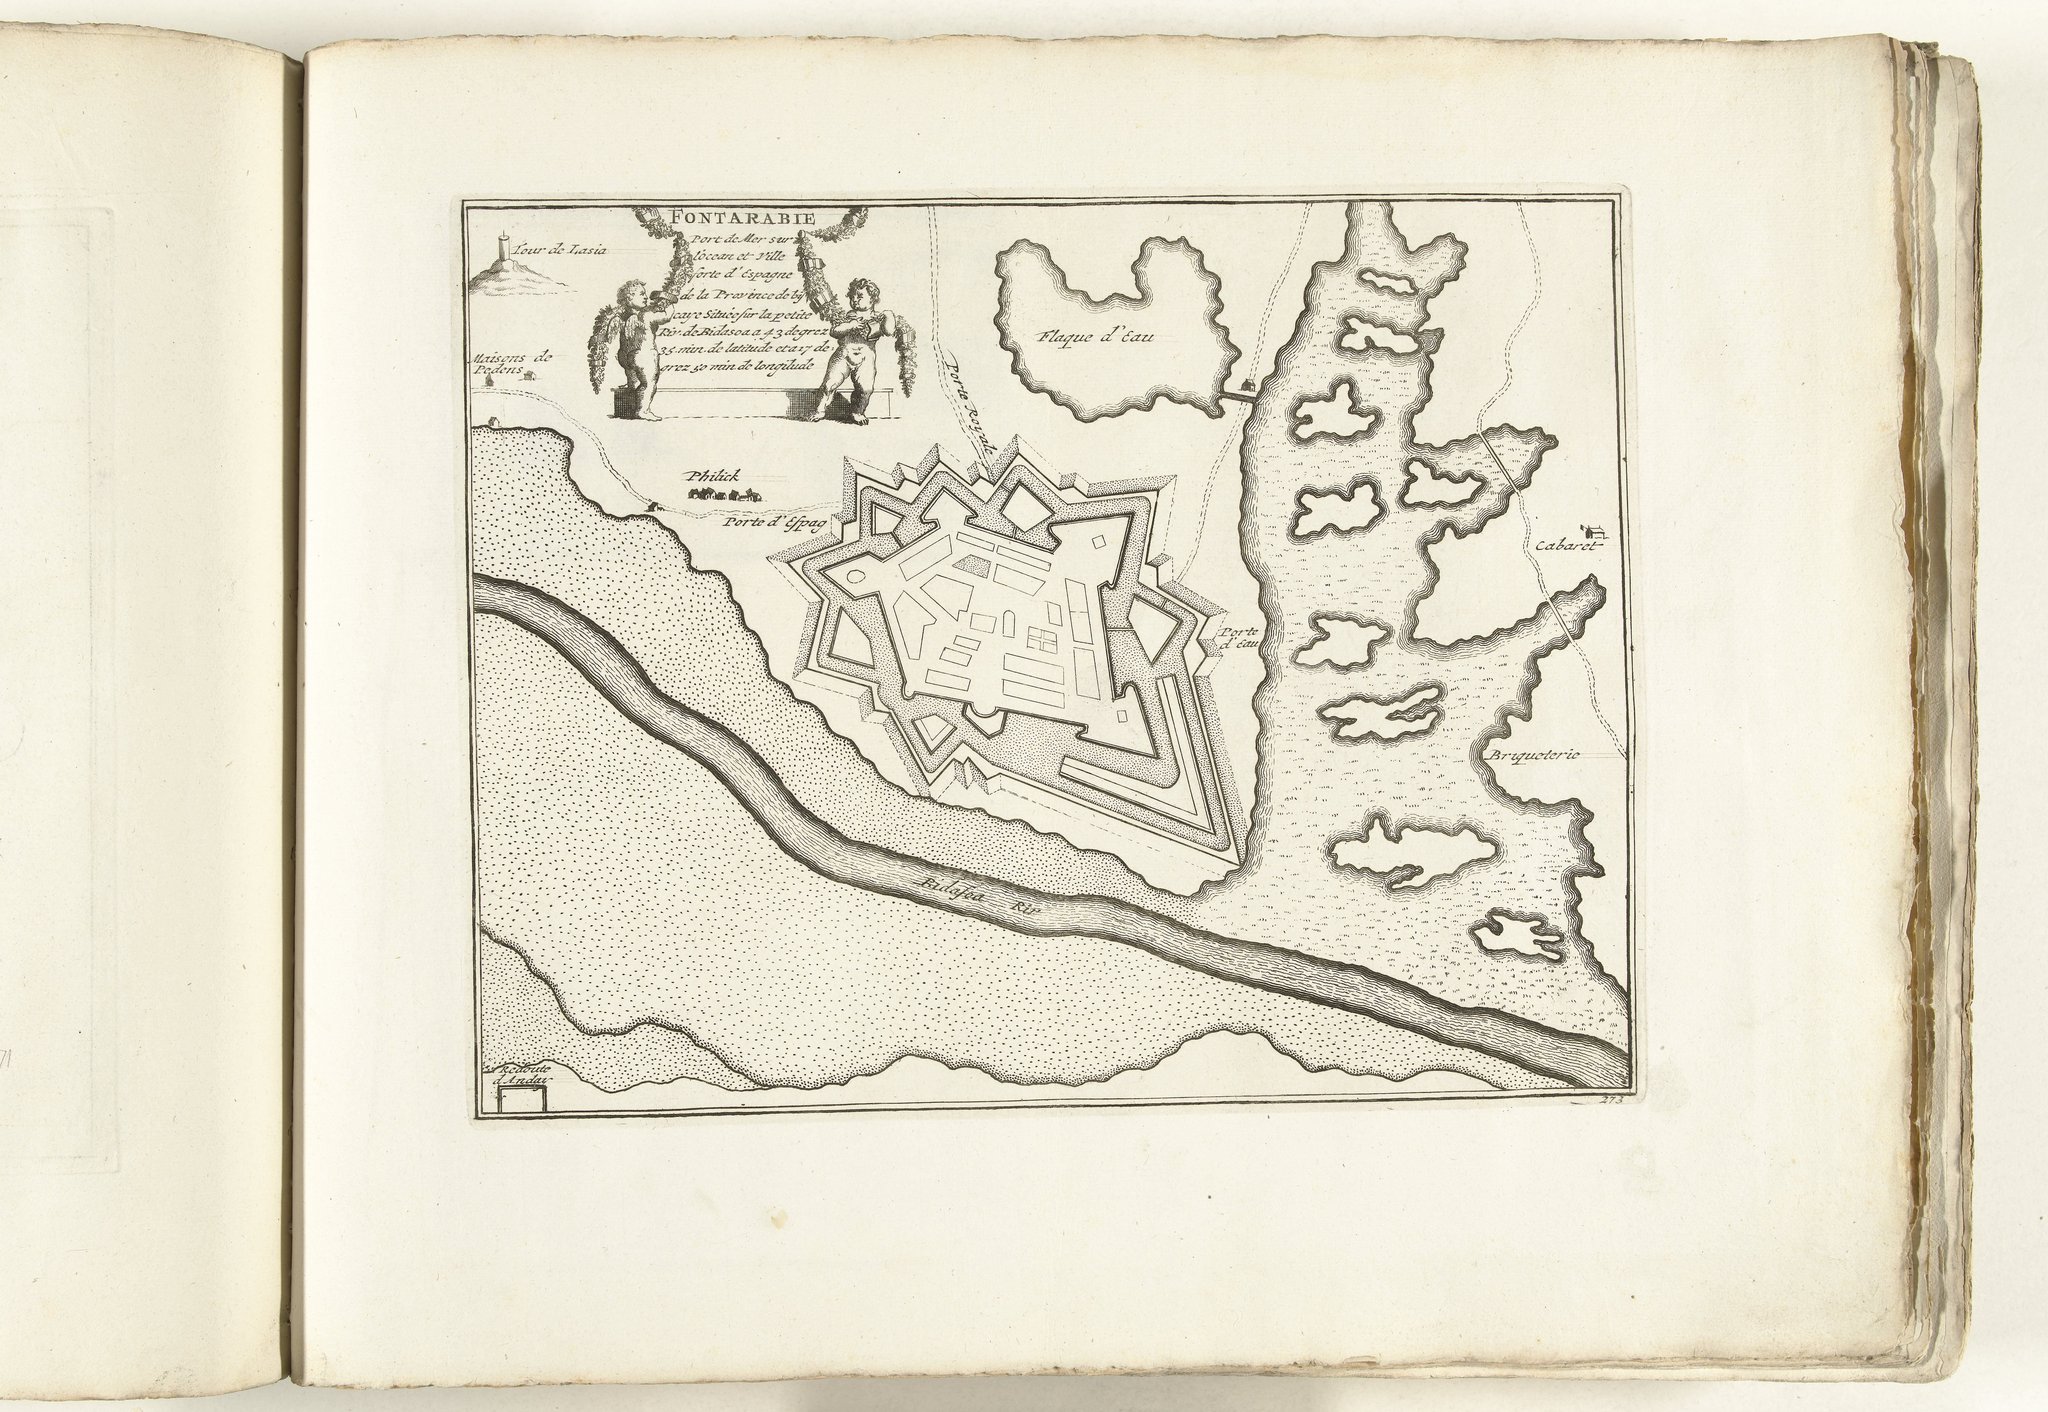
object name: map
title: Fontarabie Port de Mer (...)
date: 1702-1703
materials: paper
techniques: etching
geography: amsterdam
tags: fortress, maps of cities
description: Plattegrond van de versterkingen om de Franse stad Fuenterrabía. Plaat nr. 273 in het prentwerk bestaande in totaal uit 276 genummerde platen van vermaarde sterke steden en vestingen in het kader van de Spaanse Successieoorlog. Voor het merendeel zijn deze platen gekopieerd naar de anonieme Franse platen: in Les forces de l'Europe en in: Le theatre de la guerre, dans les Pays-Bas, beide oorspronkelijk uitgegeven door Nicolas de Fer te Parijs (1693-1697) in het kader van de Negenjarige Oorlog. Titel en opschriften in de plaat in het Frans.